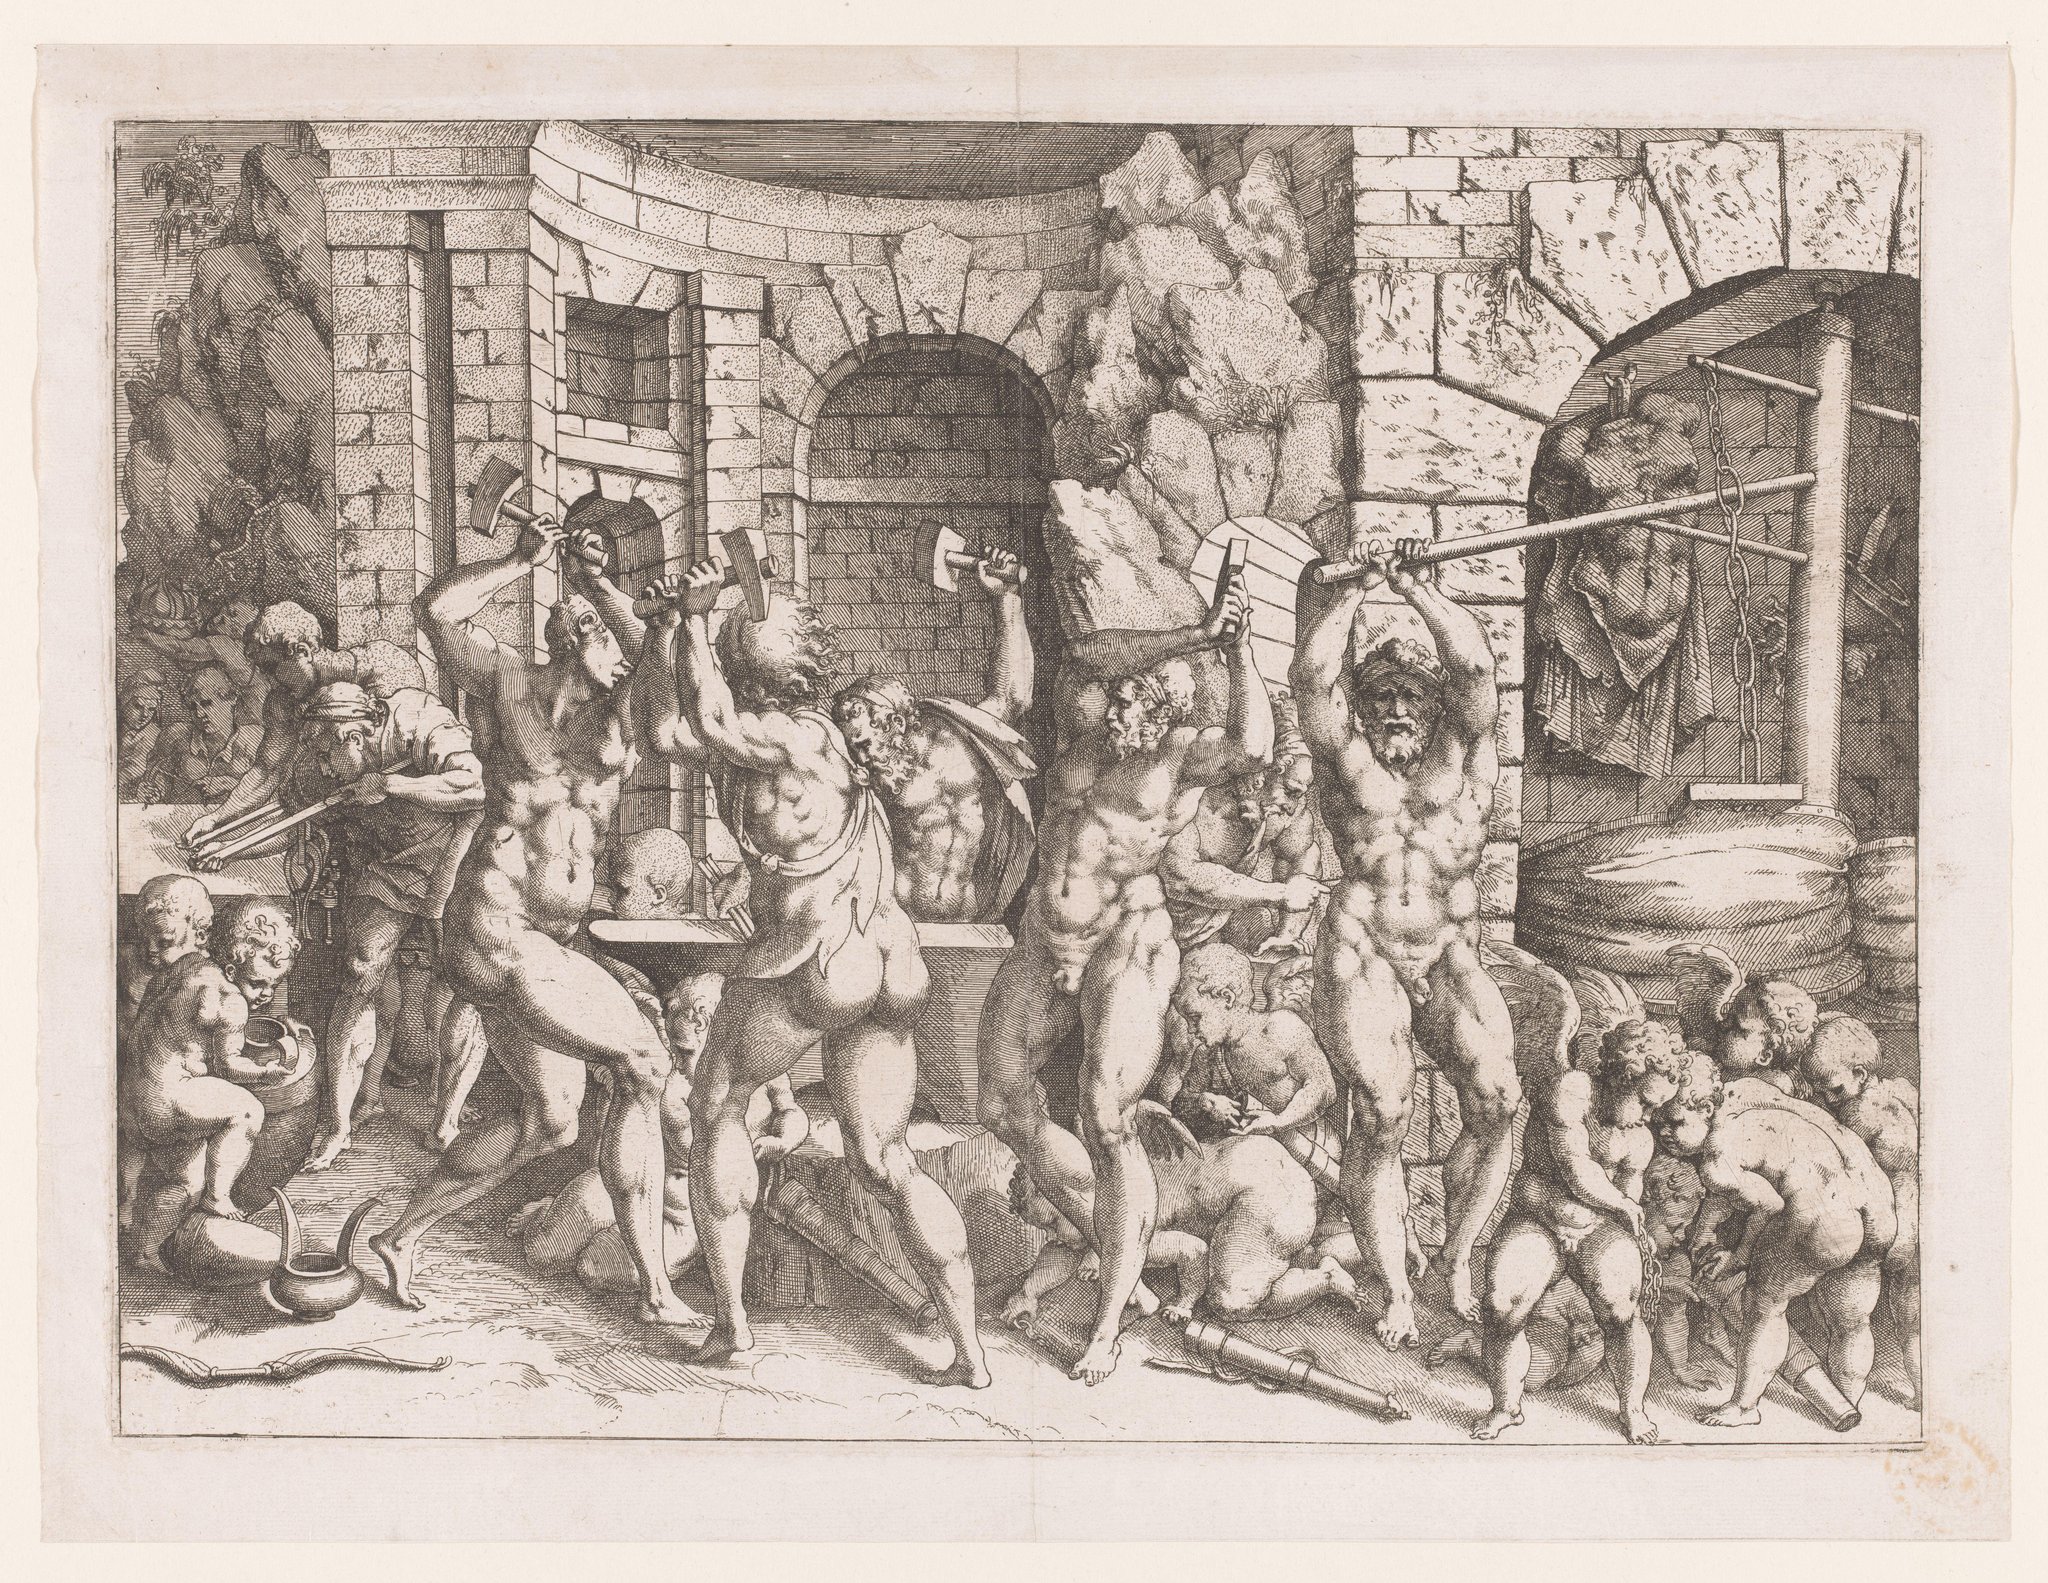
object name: print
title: Vulcanus en de cyclopen smeden pijlen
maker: master of the story of cadmus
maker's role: print maker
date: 1540-1550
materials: paper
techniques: etching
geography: france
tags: (story of) cyclopes as fellow blacksmiths of vulcan, in the god's forge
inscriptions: collector's mark: Lugt 240